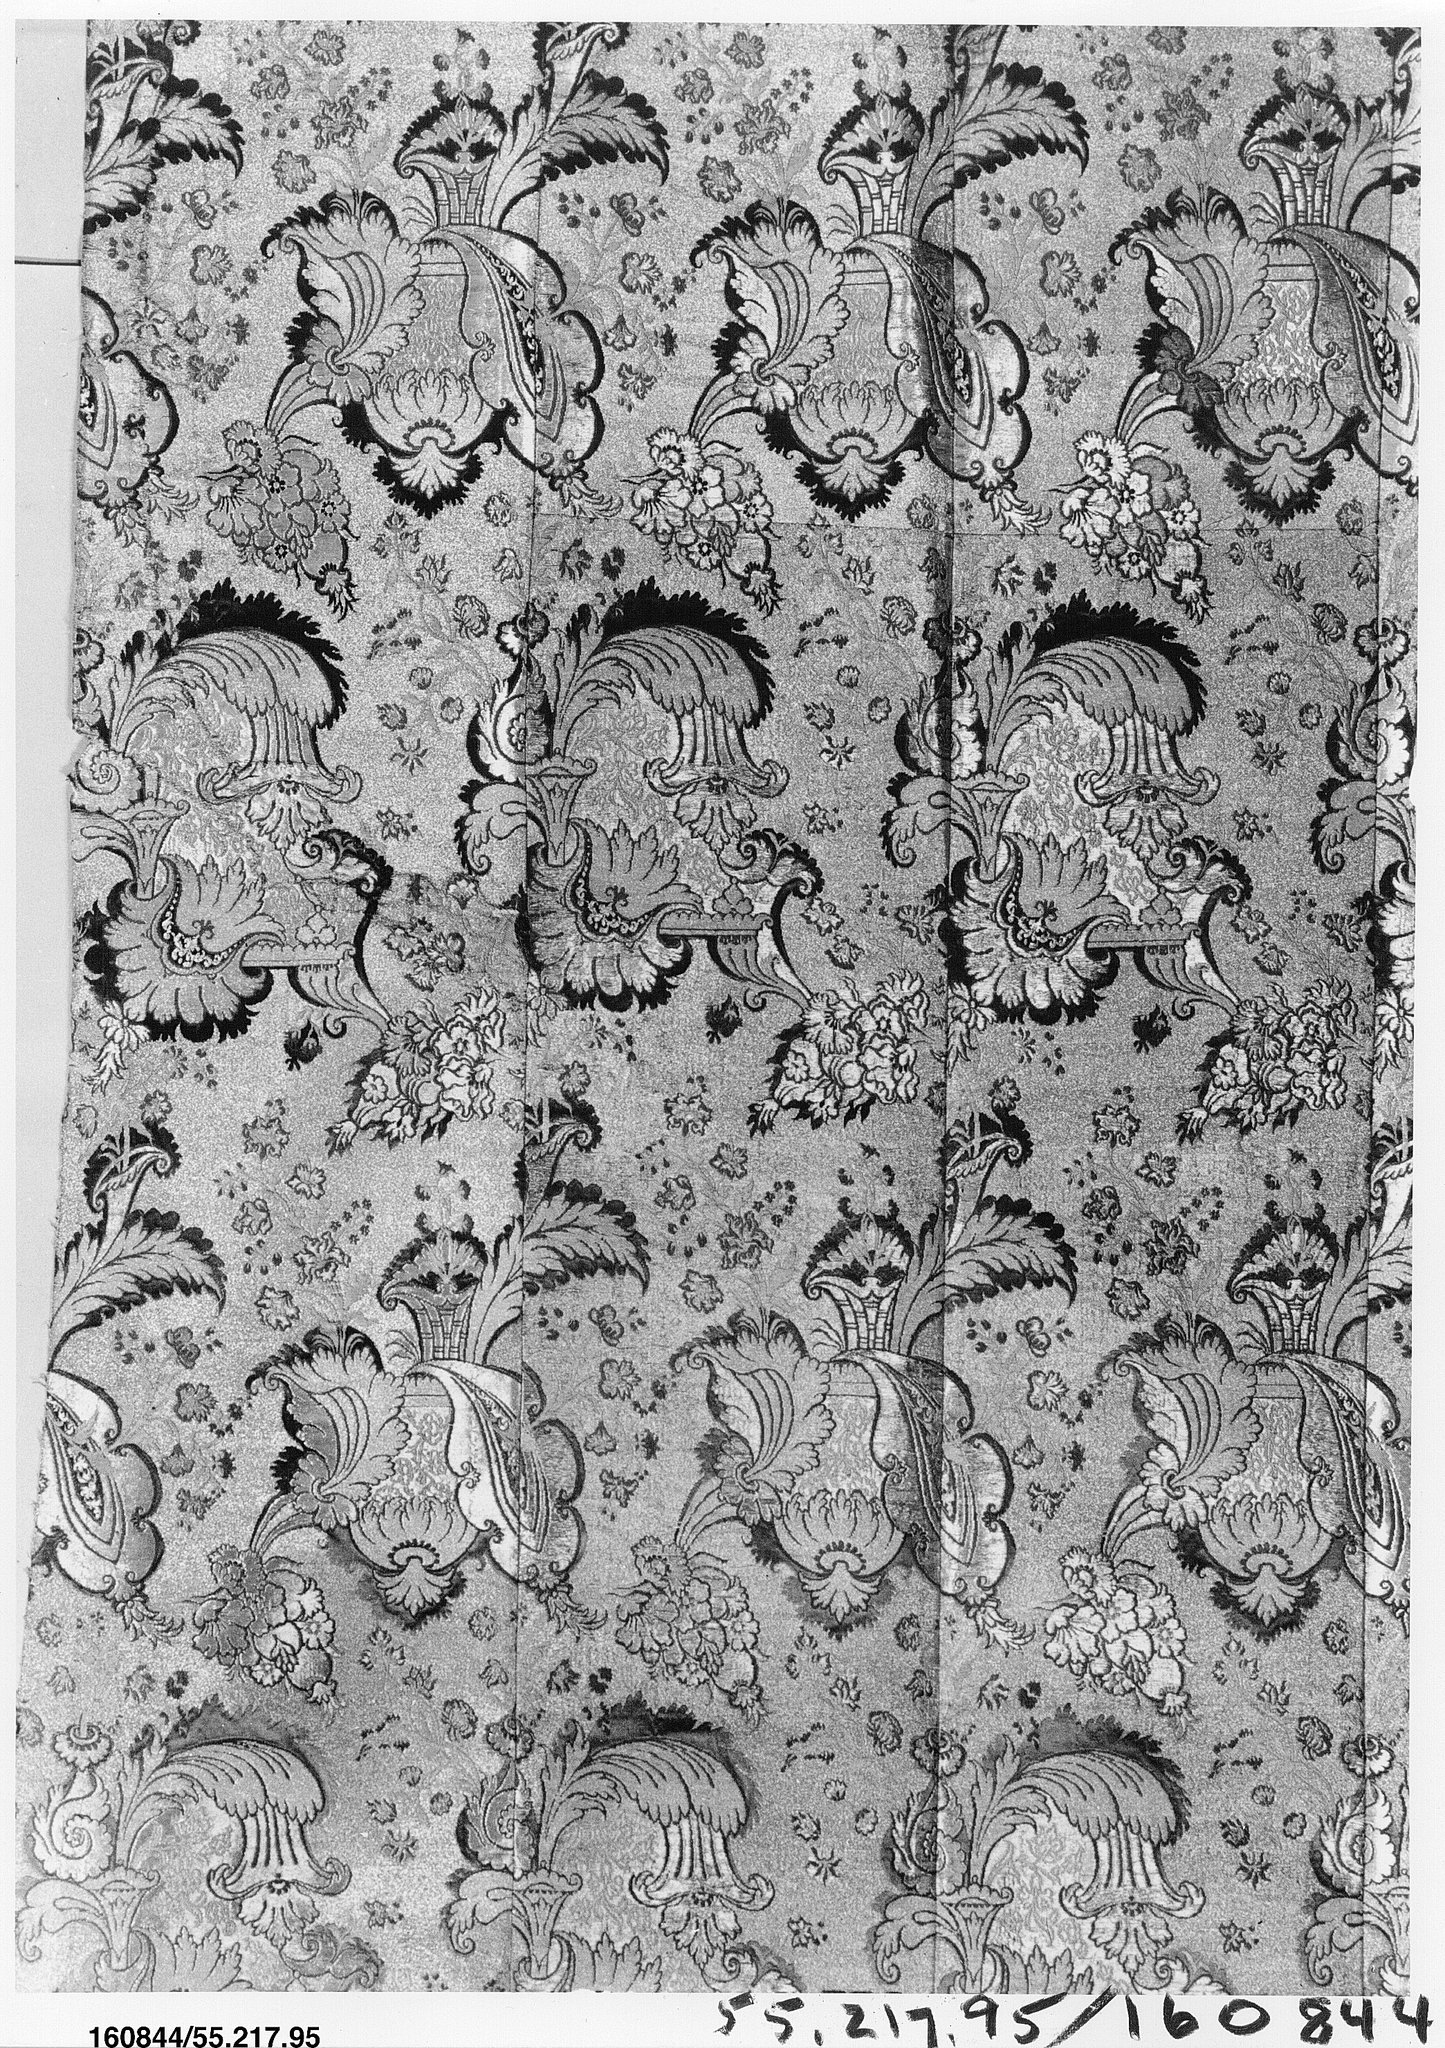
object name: piece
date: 1701-1750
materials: metal thread, silk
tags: leaves